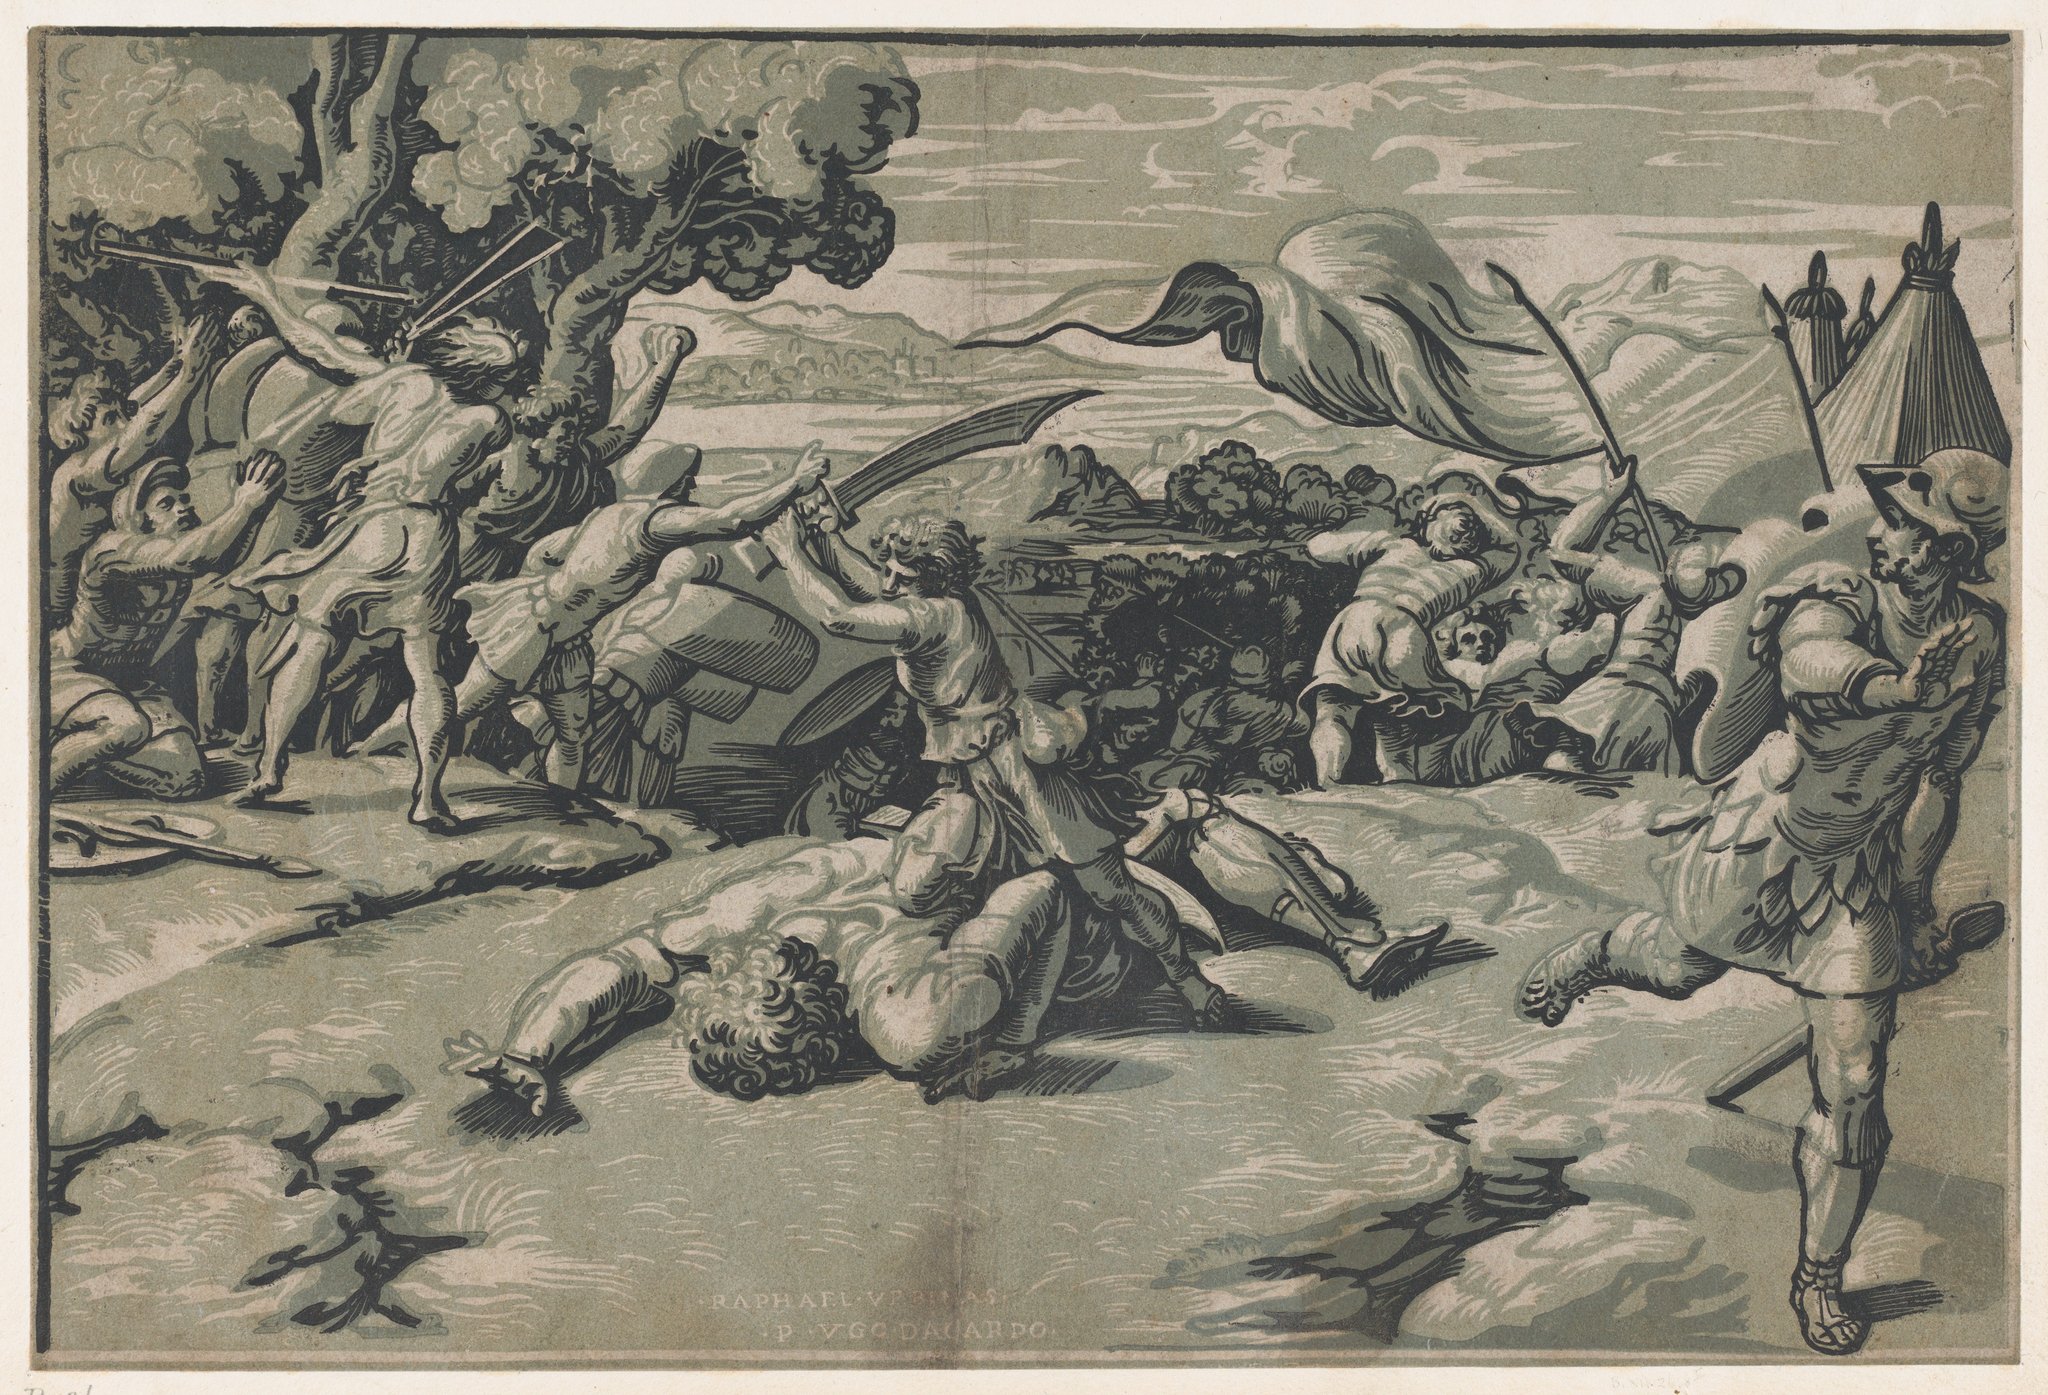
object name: print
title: David and Goliath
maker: ugo da carpi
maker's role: artist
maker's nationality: italian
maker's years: 1480-1532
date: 1520-1527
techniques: woodcut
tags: battles,men,david